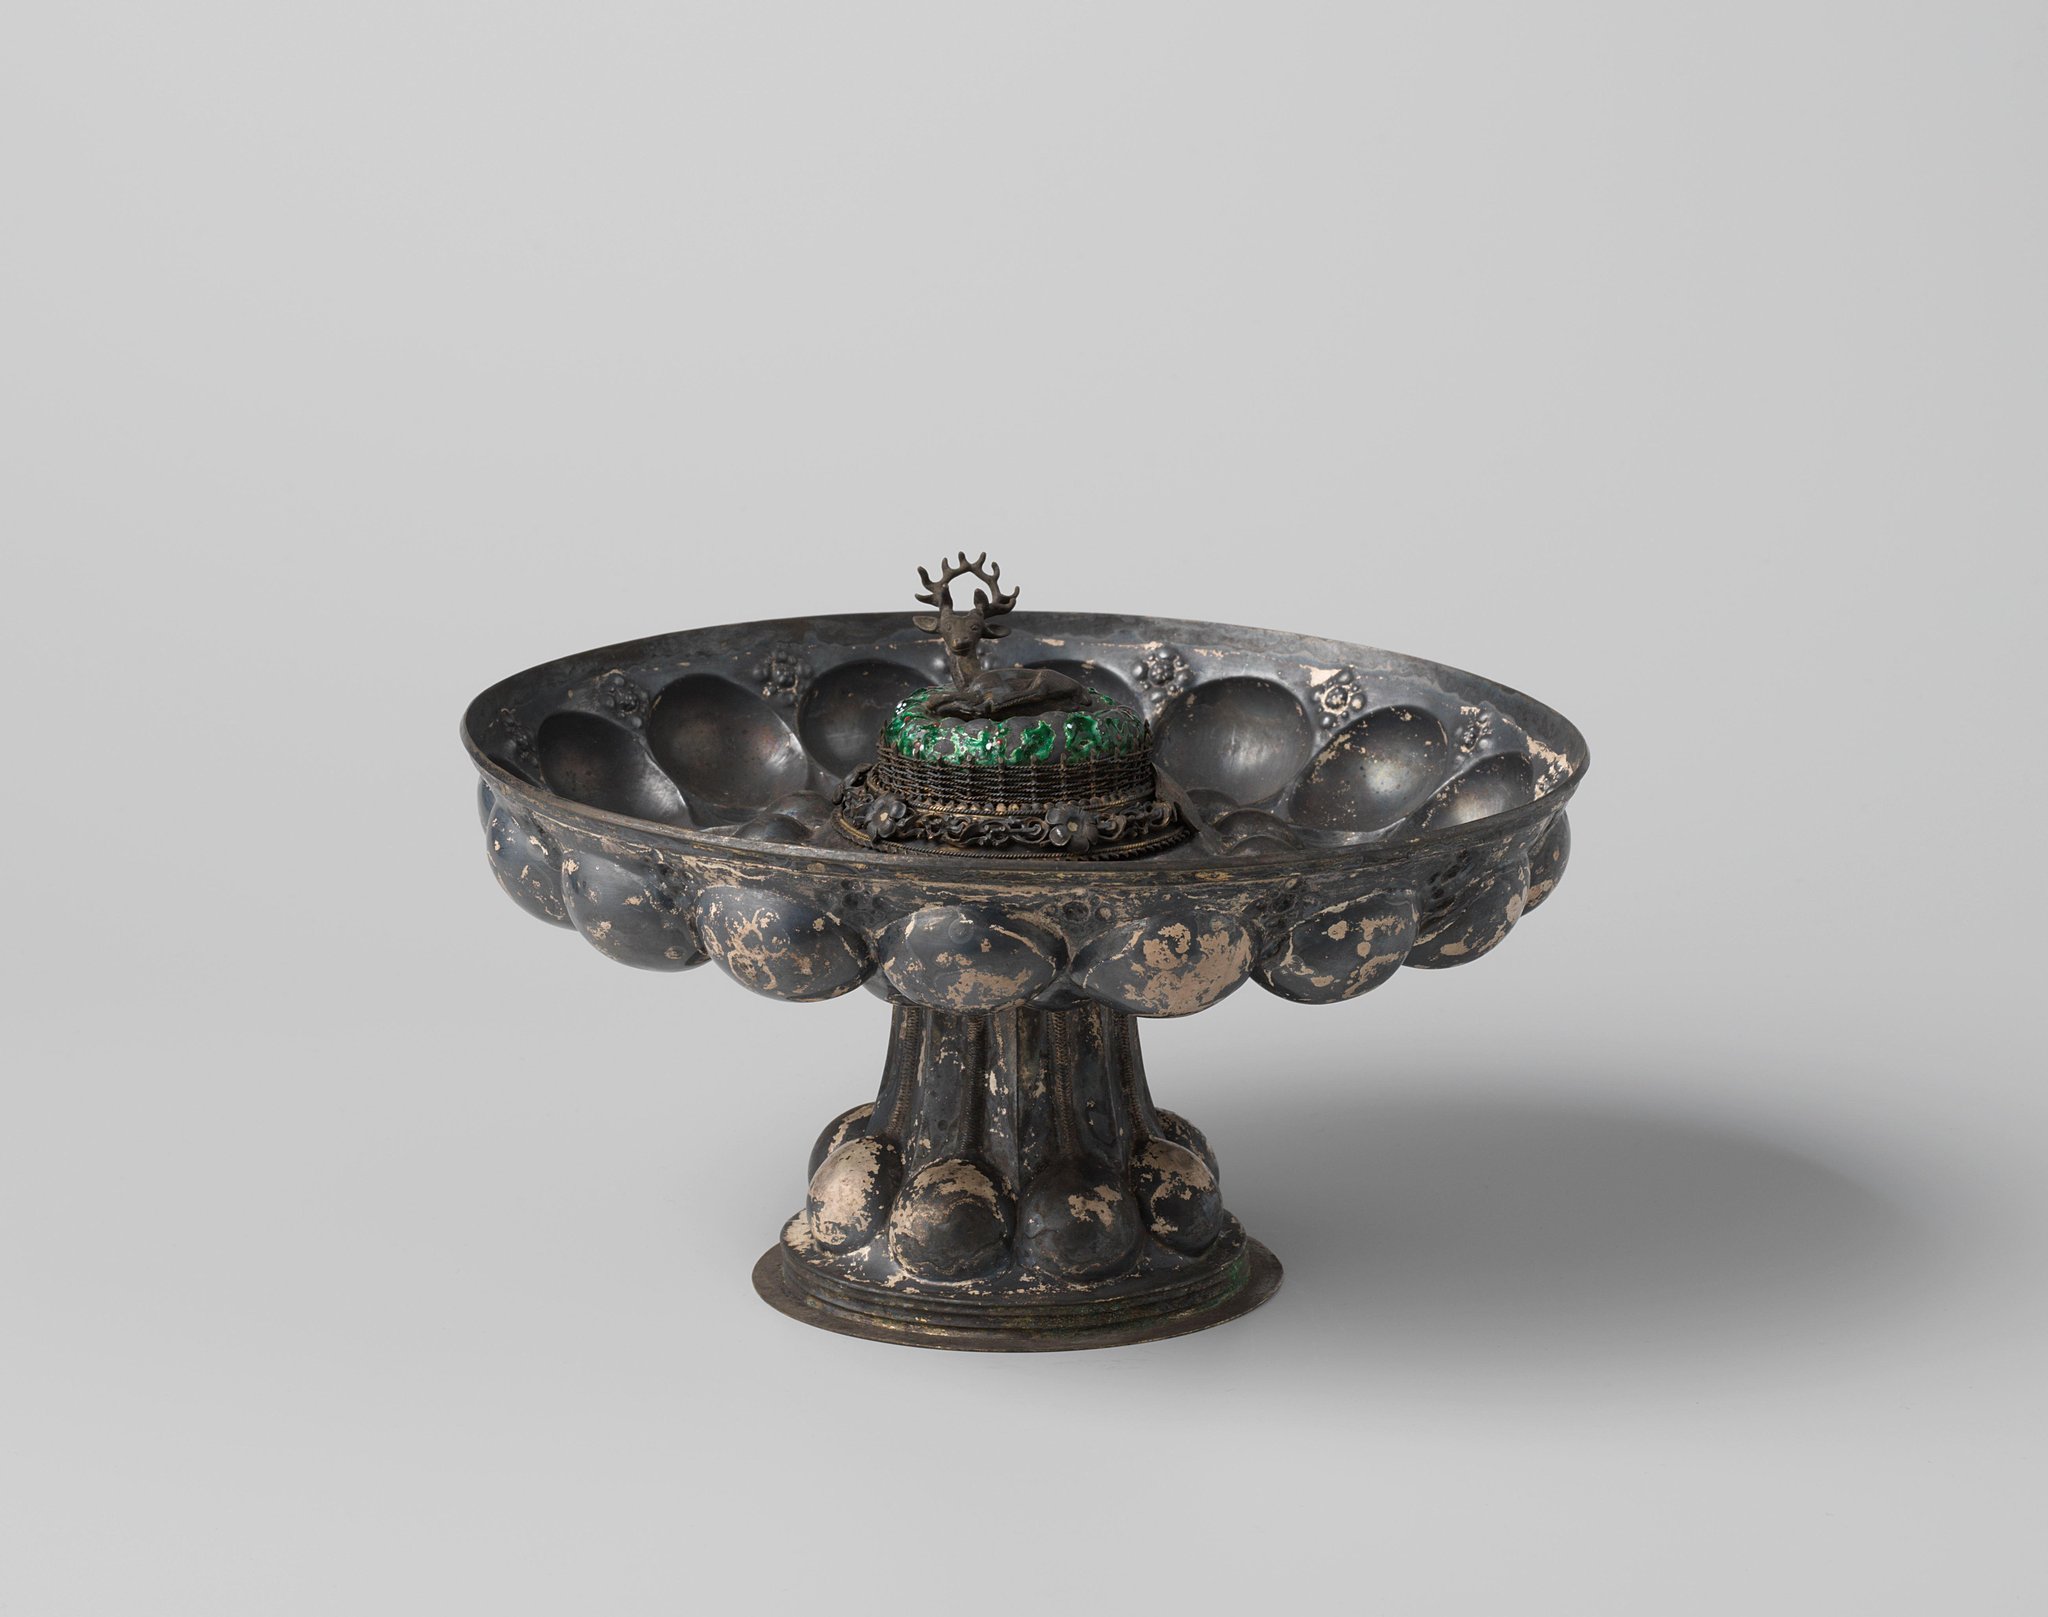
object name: dish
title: Galvanoplastische reproductie van een schaal met een hert binnen omheining uit het Lüneburger Ratssilber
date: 1881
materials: copper, silver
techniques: gilding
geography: berlin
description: Galvanoplastische reproductie van een schaal met zwellingen, waarop liggend hert op groen email, op hoge voet van verguld zilver.